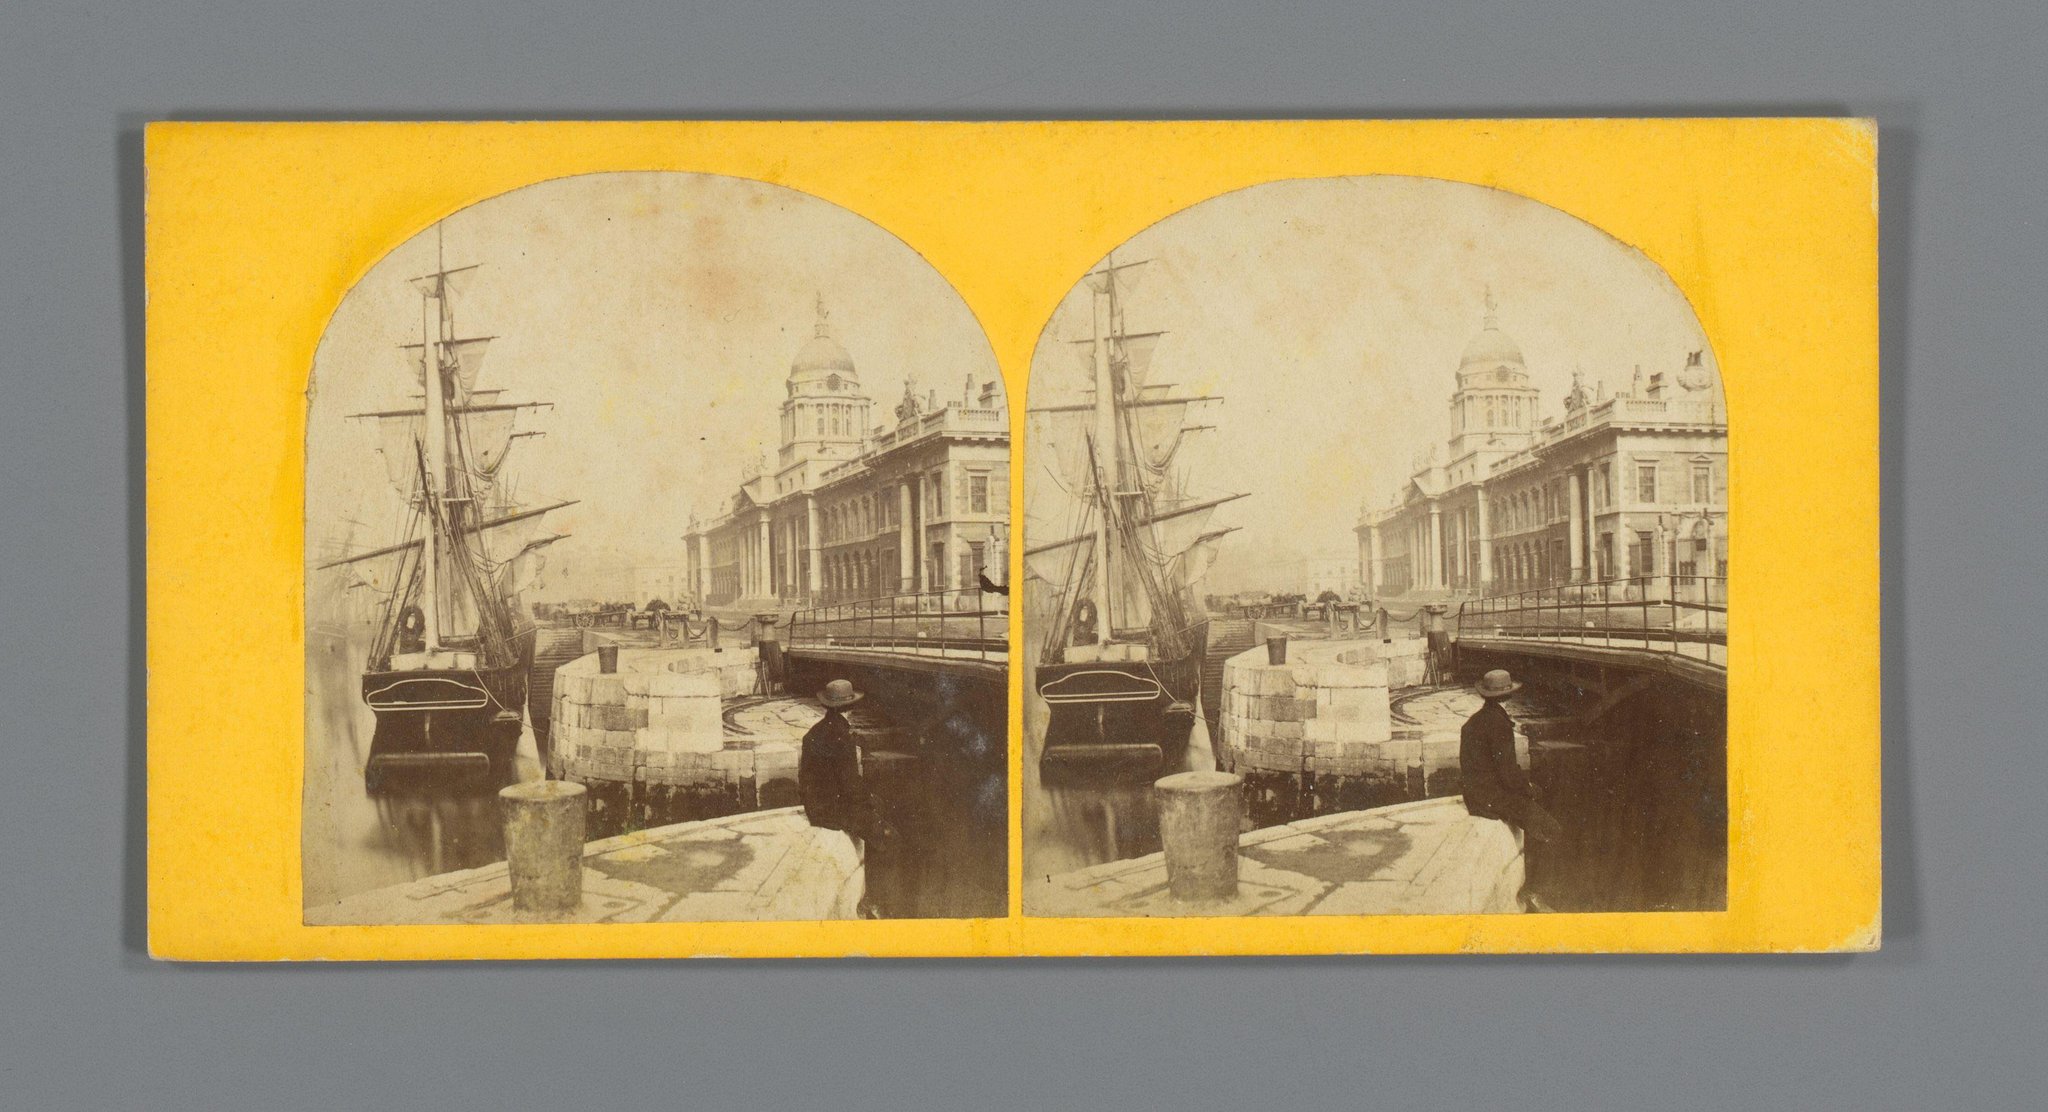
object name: stereograph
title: The Custom House, Dublin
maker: Anonymous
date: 1861-1870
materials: cardboard, paper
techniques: albumen print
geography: dublin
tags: quay